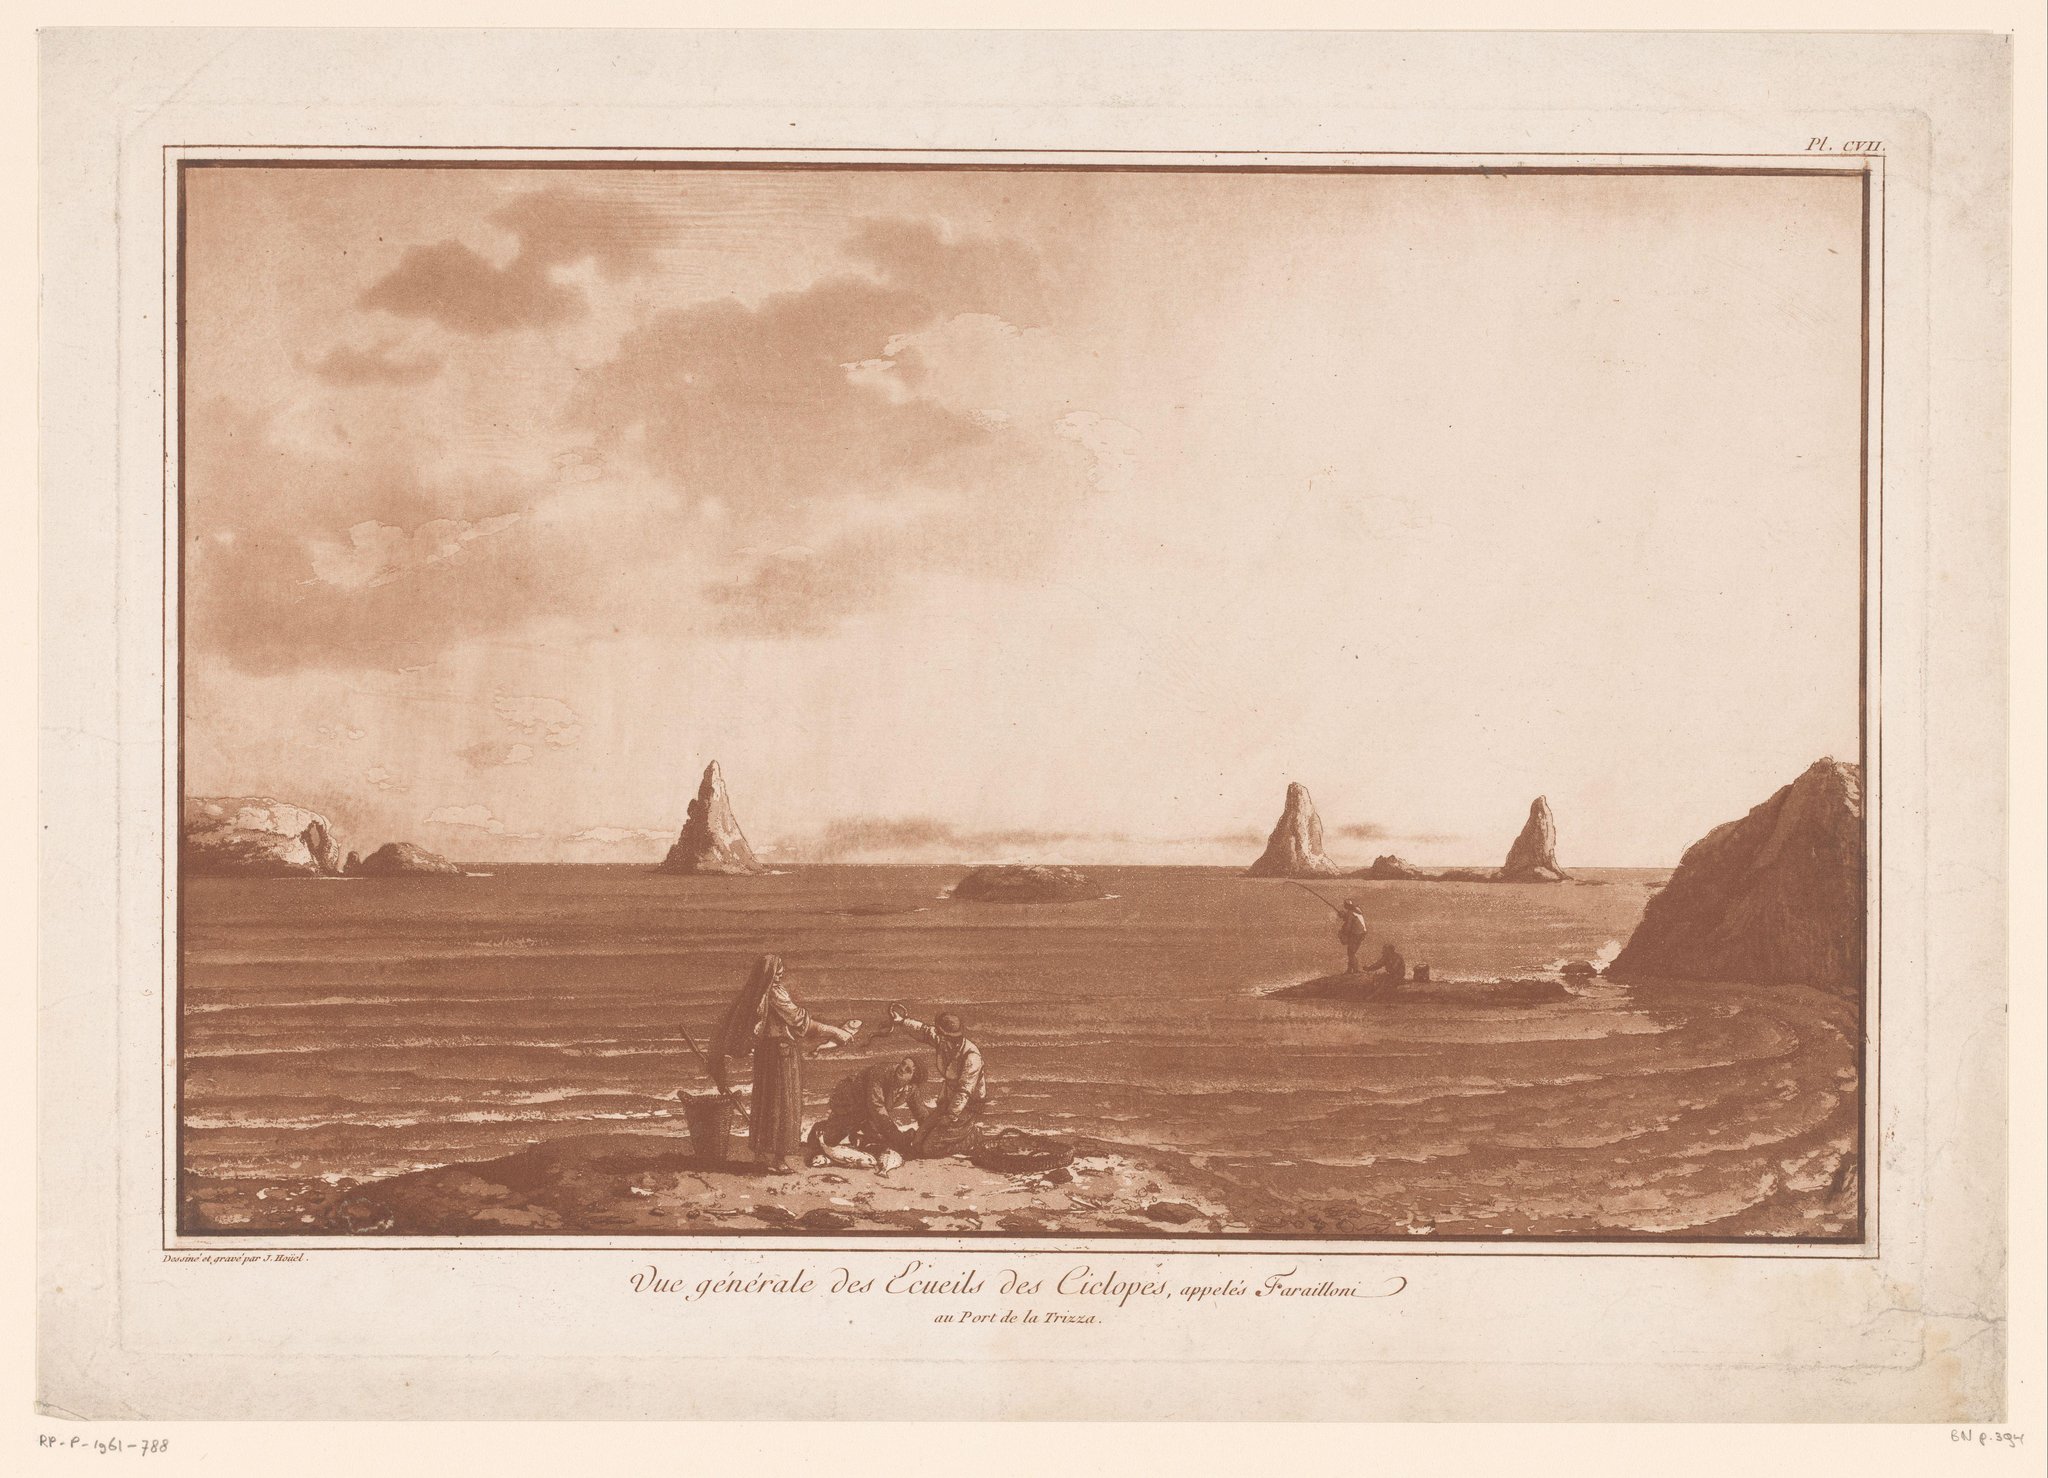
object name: print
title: Vue Générale des Ecueils des Ciclopes, appelés Farailloni au port de la Trizza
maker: jean pierre louis laurent houël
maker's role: draughtsman, painter, print maker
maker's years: 1735-1813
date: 1782-1787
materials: paper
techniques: aquatint, etching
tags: rock-formations, sea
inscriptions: collector's mark: Lugt 2228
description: Maakt deel uit van een serie prenten met voorstellingen van Sicilië, Malta en Lipari.